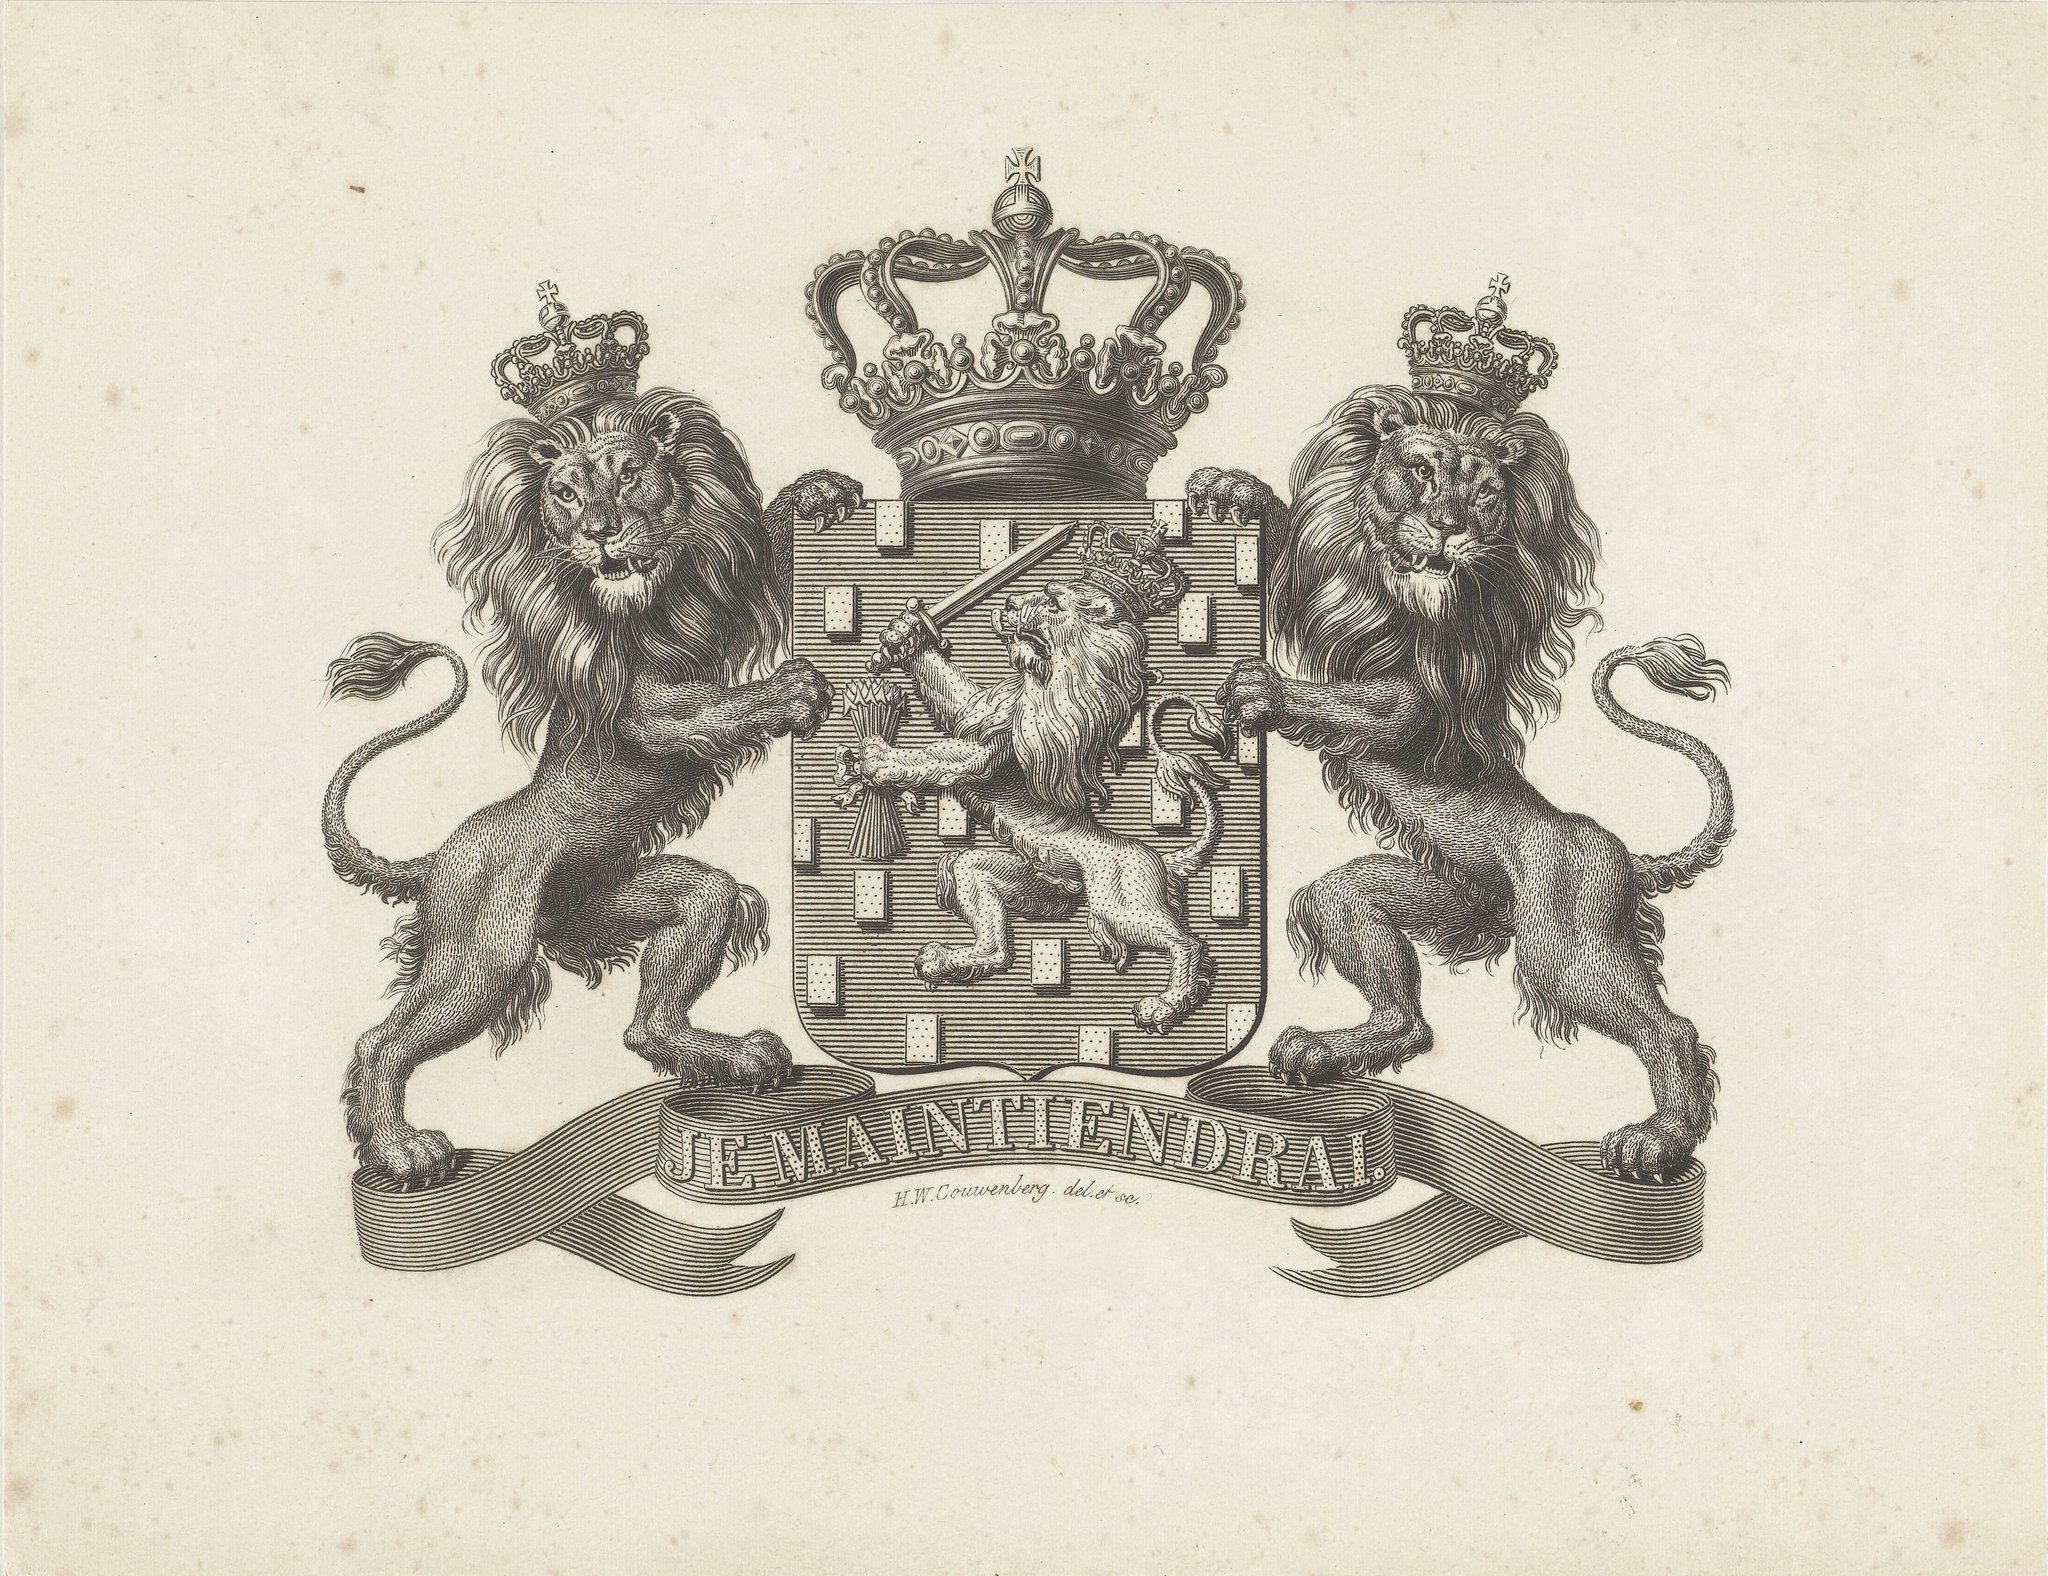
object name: print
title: Wapen van Nederland met motto: Je Maintiendrai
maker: henricus wilhelmus couwenberg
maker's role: draughtsman, print maker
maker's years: 1814-1845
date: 1830-1845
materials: paper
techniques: etching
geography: amsterdam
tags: coat of arms (as symbol of the state, etc.)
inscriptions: inscription: ‘paspoort afgegeveb door Mr. J.G. baron Verstolk van Soelen’, collector's mark: Lugt 2228, collector's mark: Lugt 2760